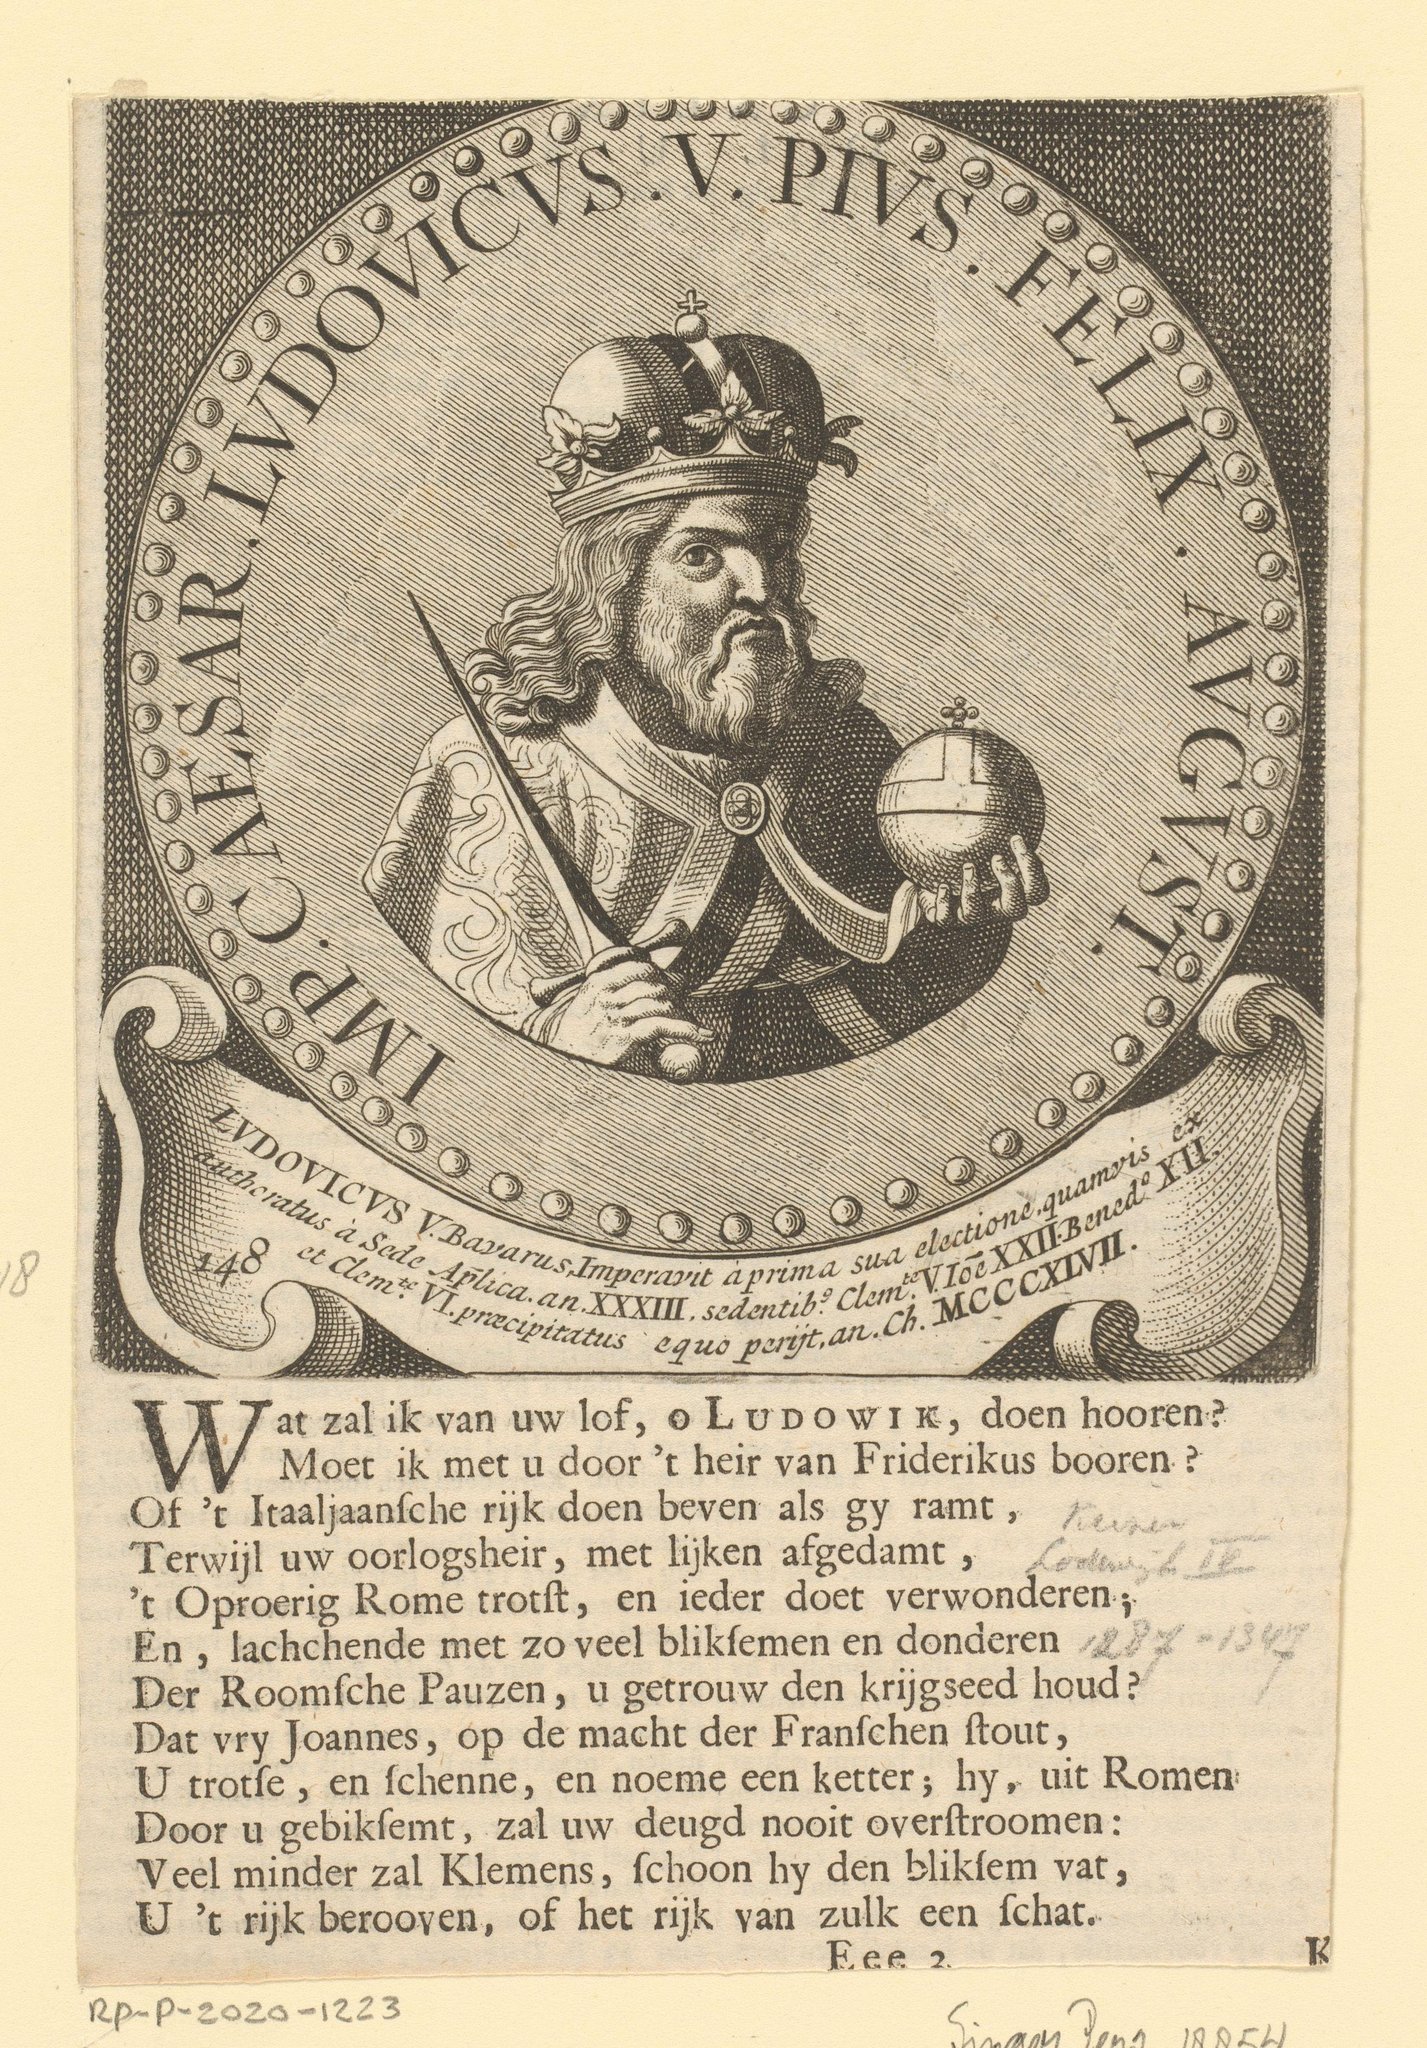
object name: book illustration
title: Portret van keizer Lodewijk de Beier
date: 1697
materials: paper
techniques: engraving, etching, letterpress printing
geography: utrecht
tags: crown (symbol of sovereignty), historical persons, hacking and thrusting weapons: sword, emperor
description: Prent uit: Bogaert, Abraham. De Roomsche monarchy, vertoont in de muntbeelden der westersche en oostersche keizeren (...). Utrecht: François Halma en Willem van de Water, 1697, p. 405. Eerste staat verschenen als grotere prent met 12 portretten, gedateerd 1695.